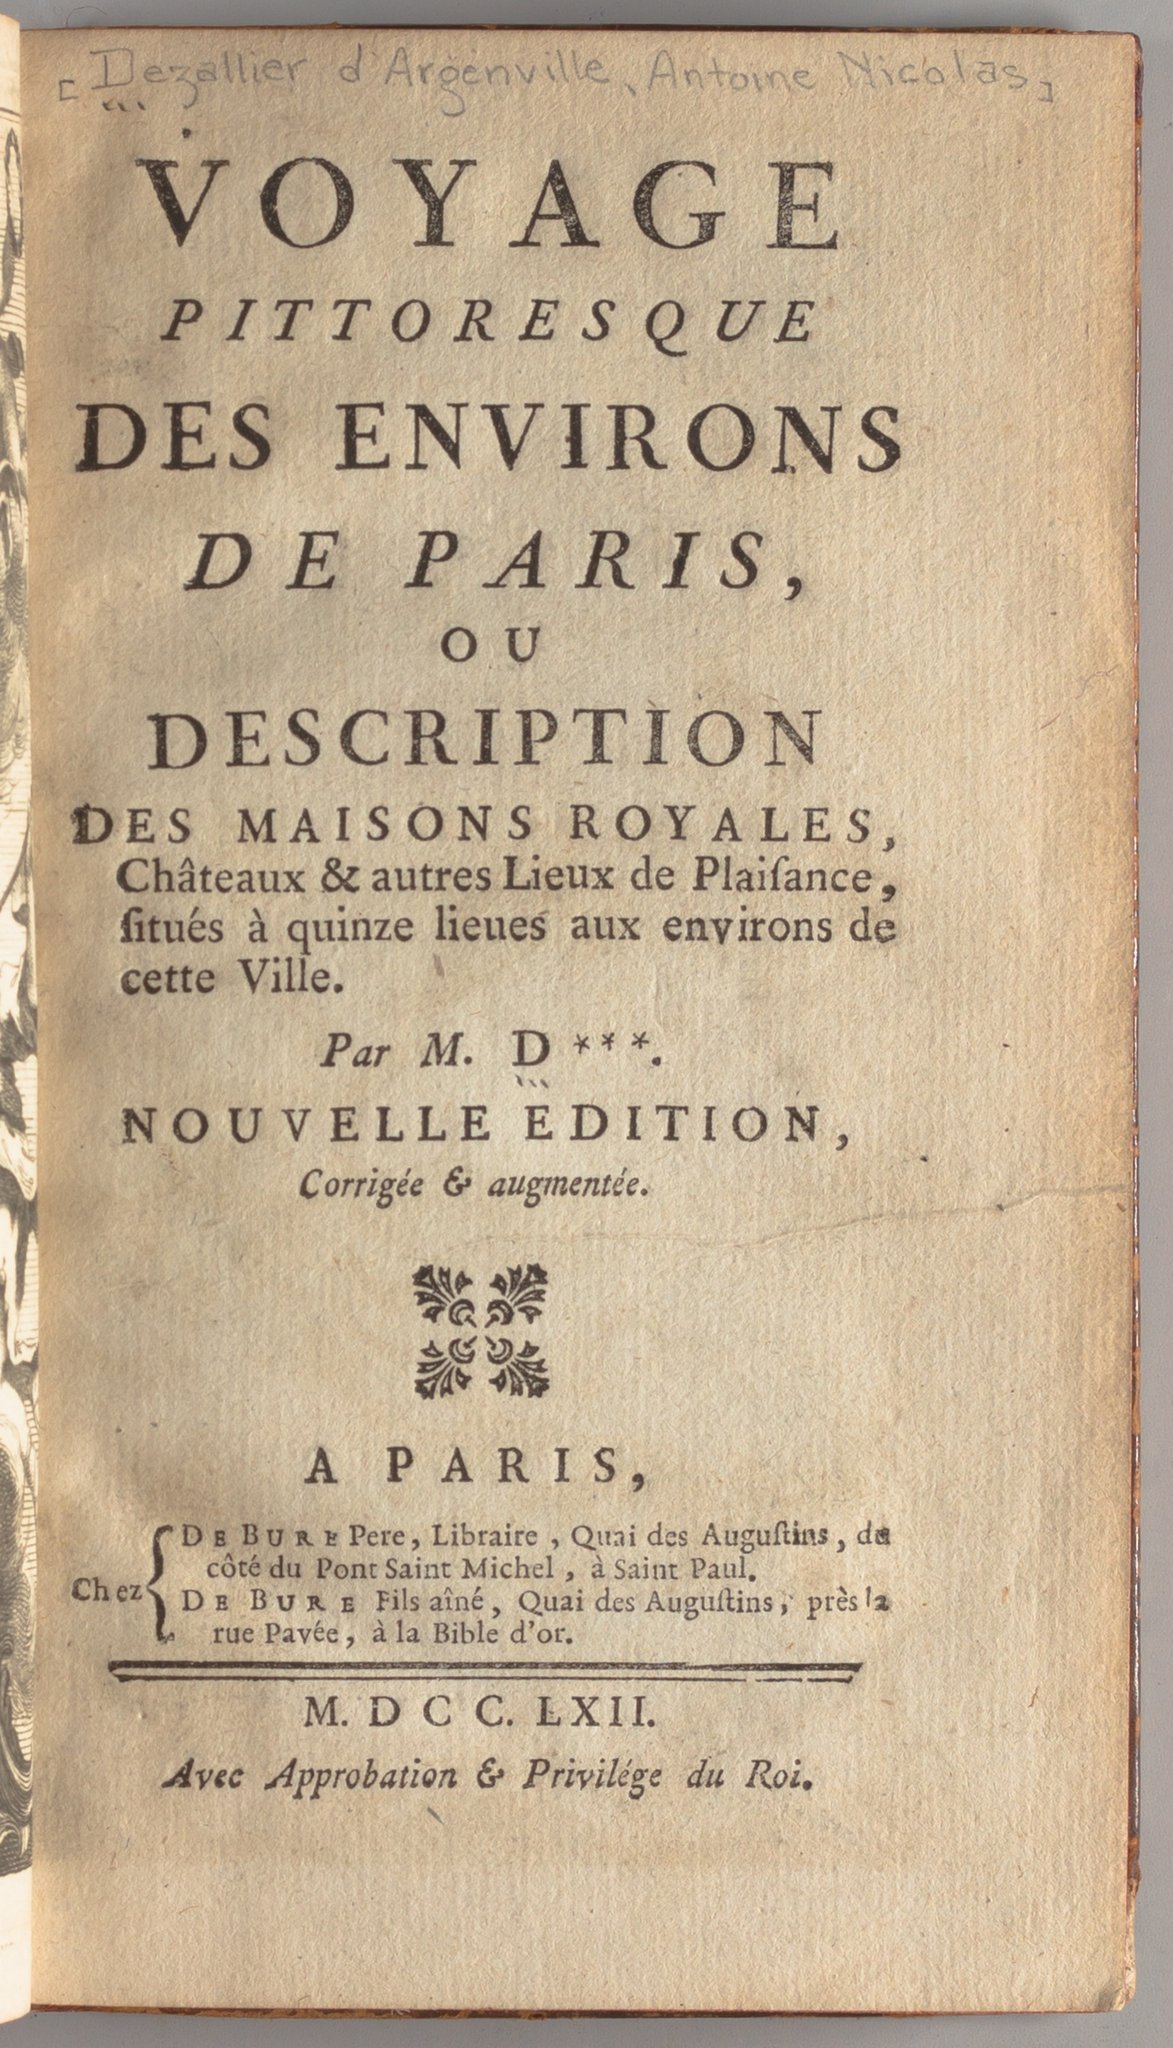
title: Voyage pittoresque des environs de Paris, ou, Description des maisons royales, châteaux & autres lieux de plaisance, situés à quinze lieues aux environs de cette ville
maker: antoine nicolas dézallier d'argenville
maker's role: author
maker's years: 1723-1794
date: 1762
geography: france